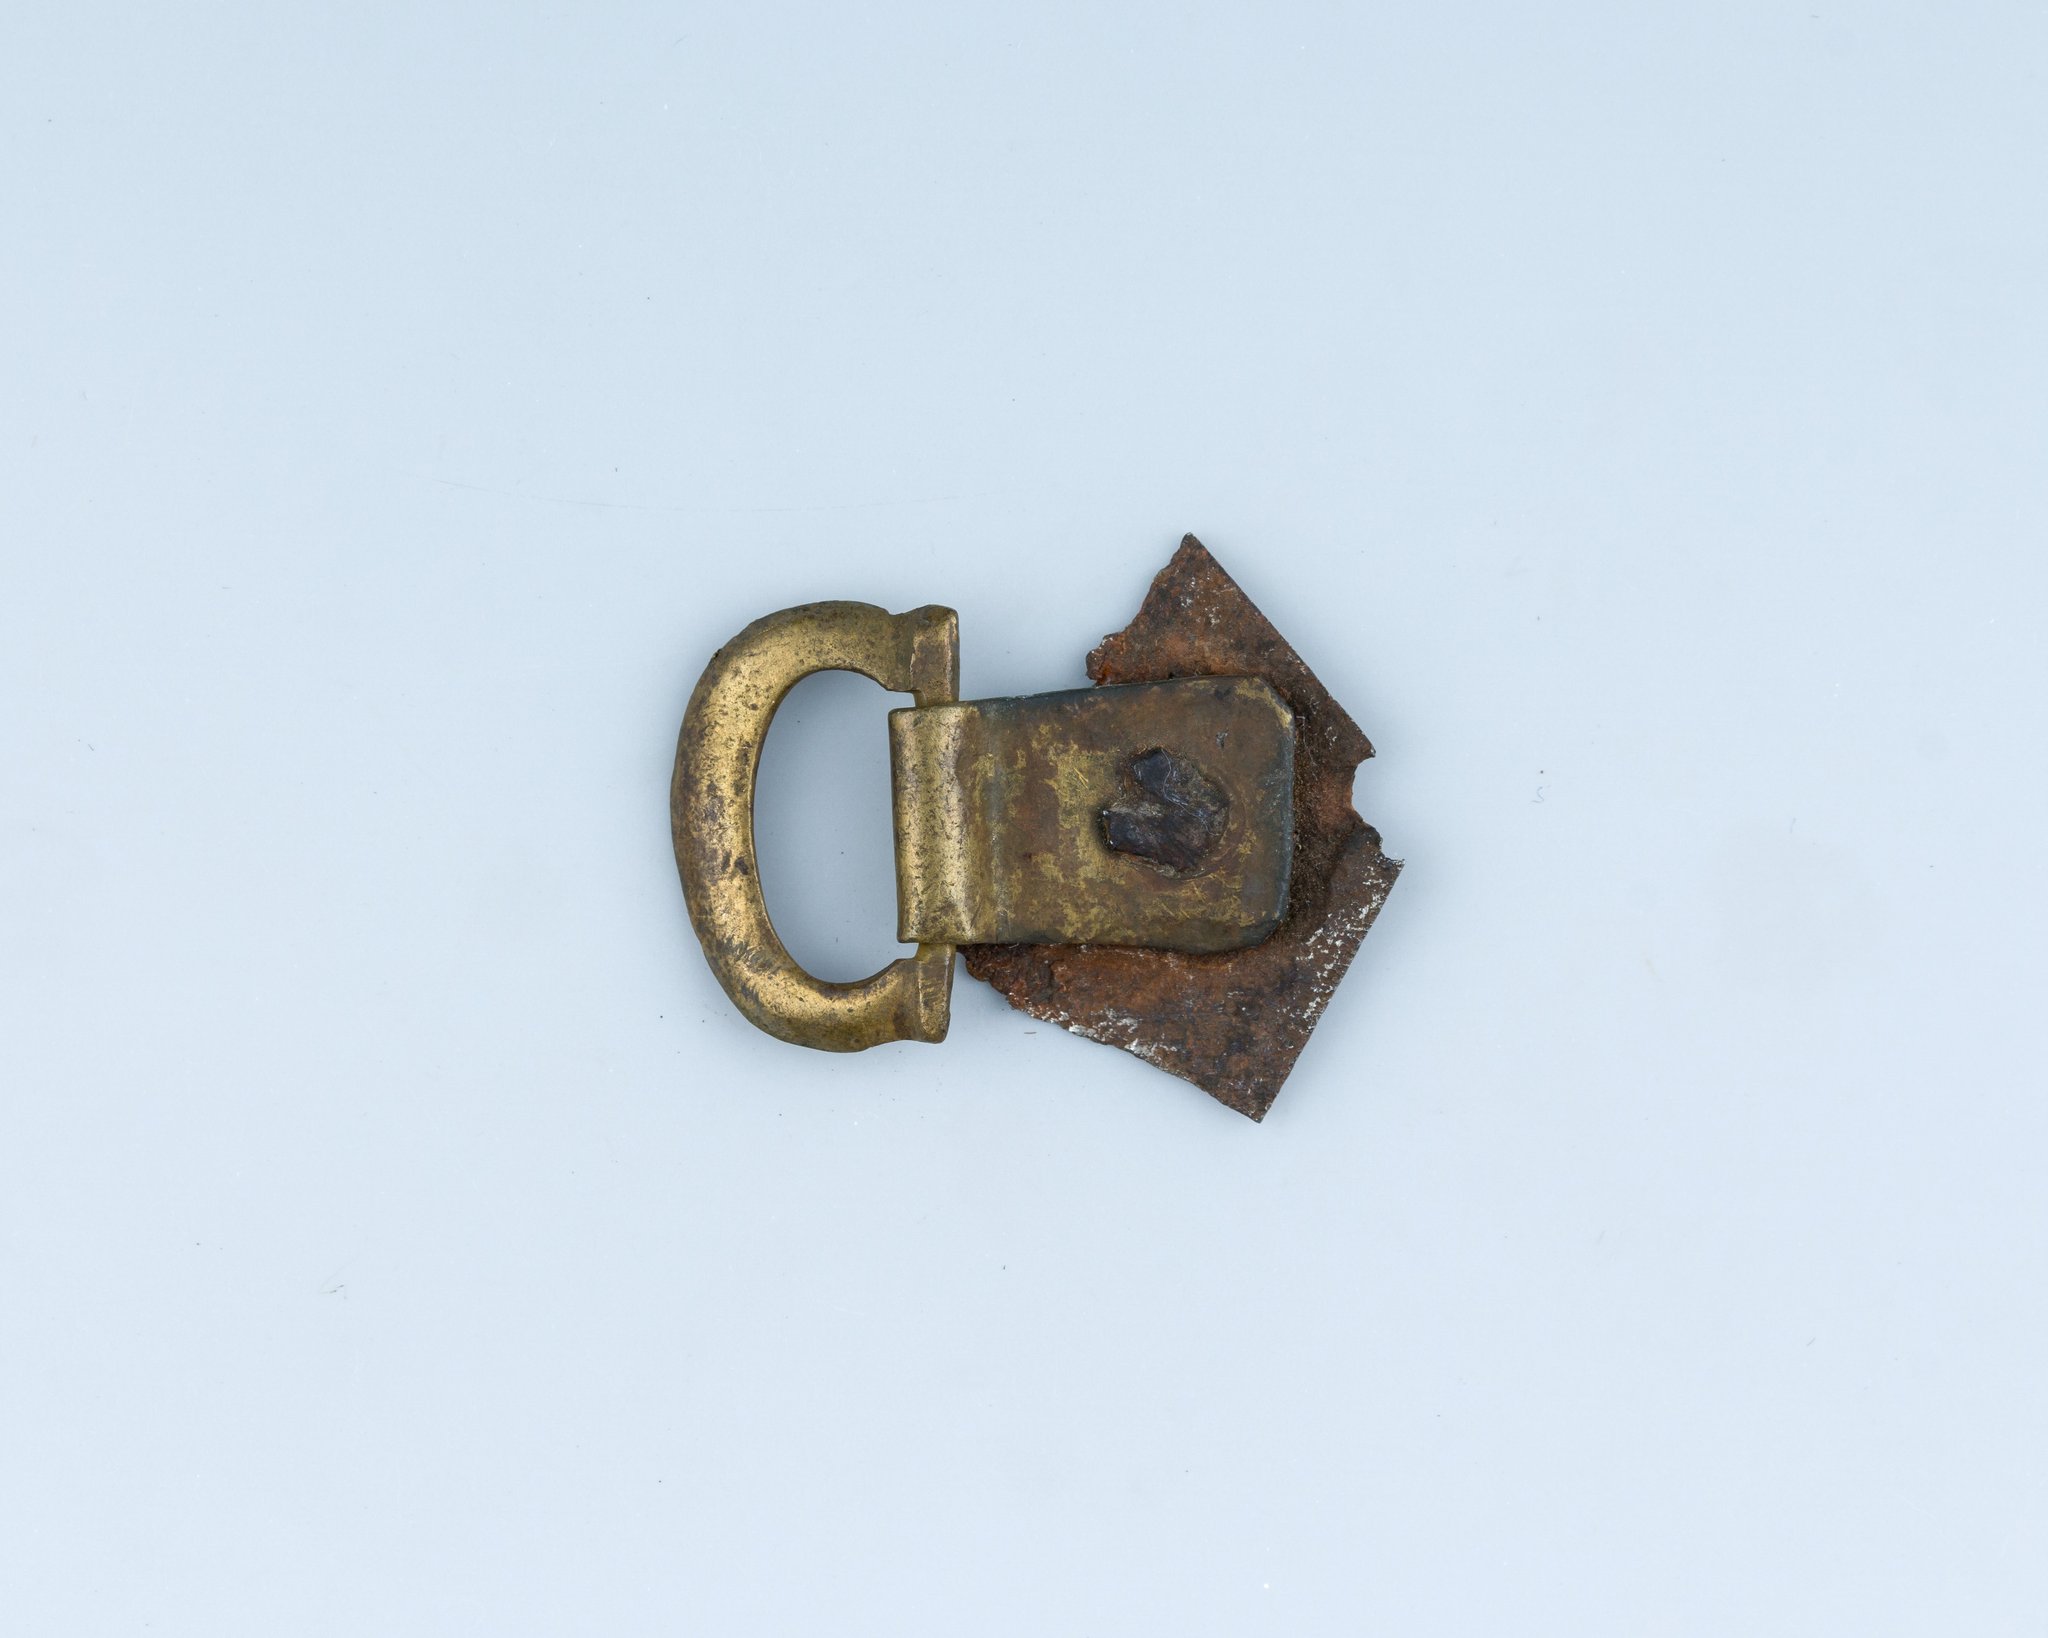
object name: loop for strap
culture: european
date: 1401-1700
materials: brass